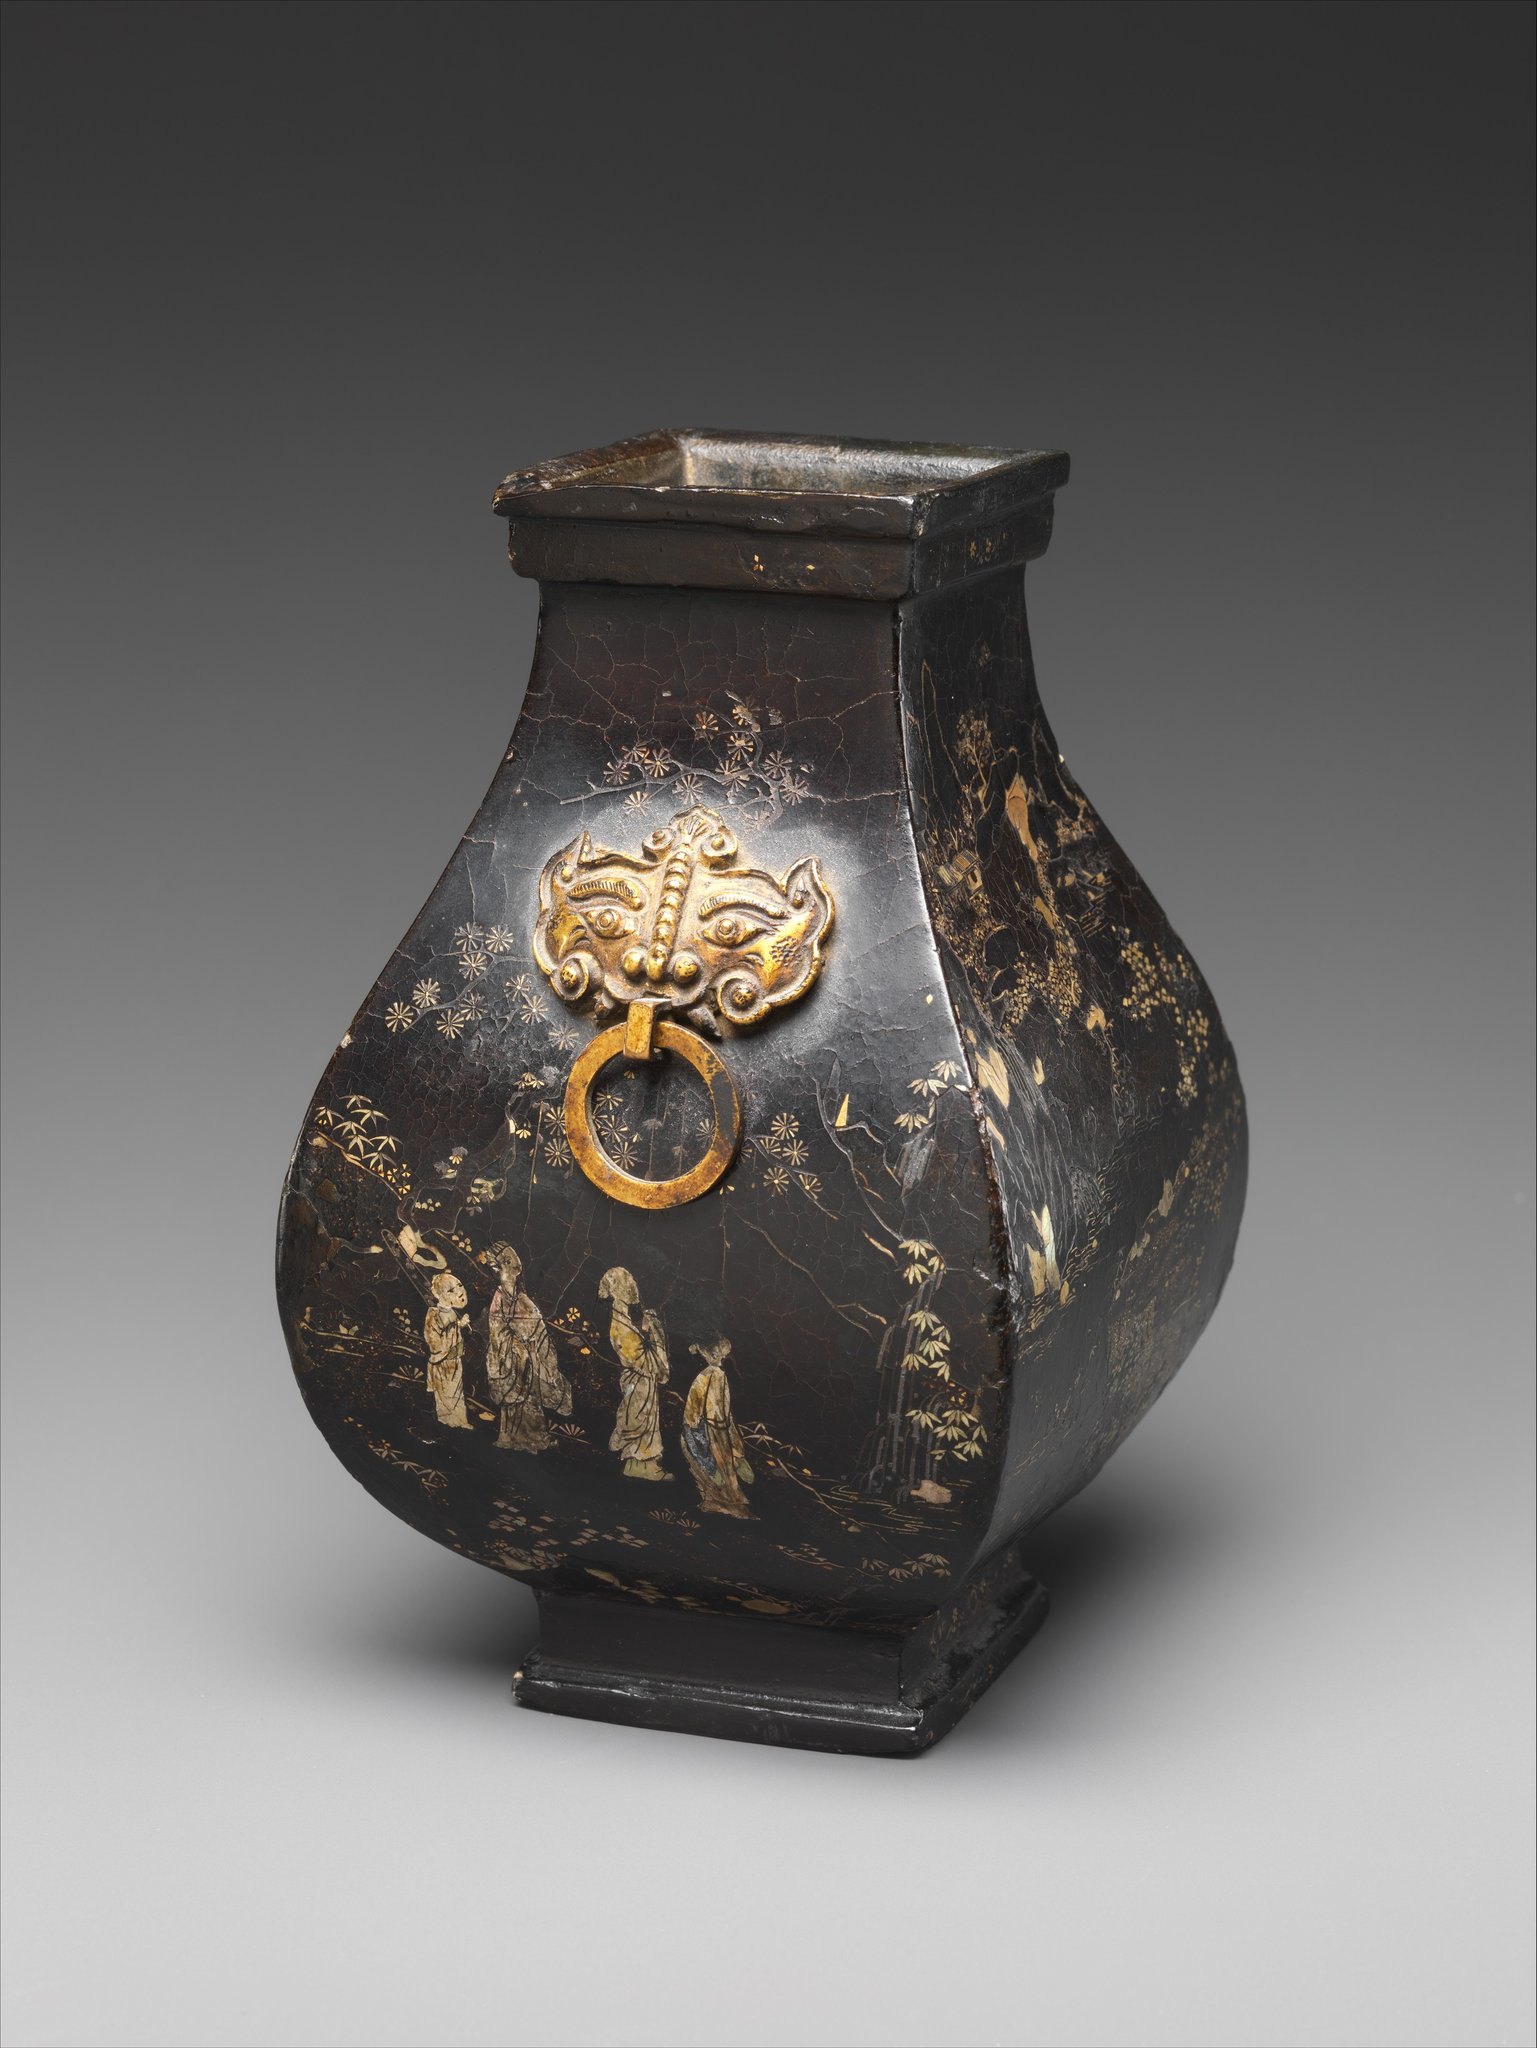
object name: vase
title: Fang-shaped vase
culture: chinese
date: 1634-1666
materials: bronze, lacquer, mother of pearl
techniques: gilding, inlay